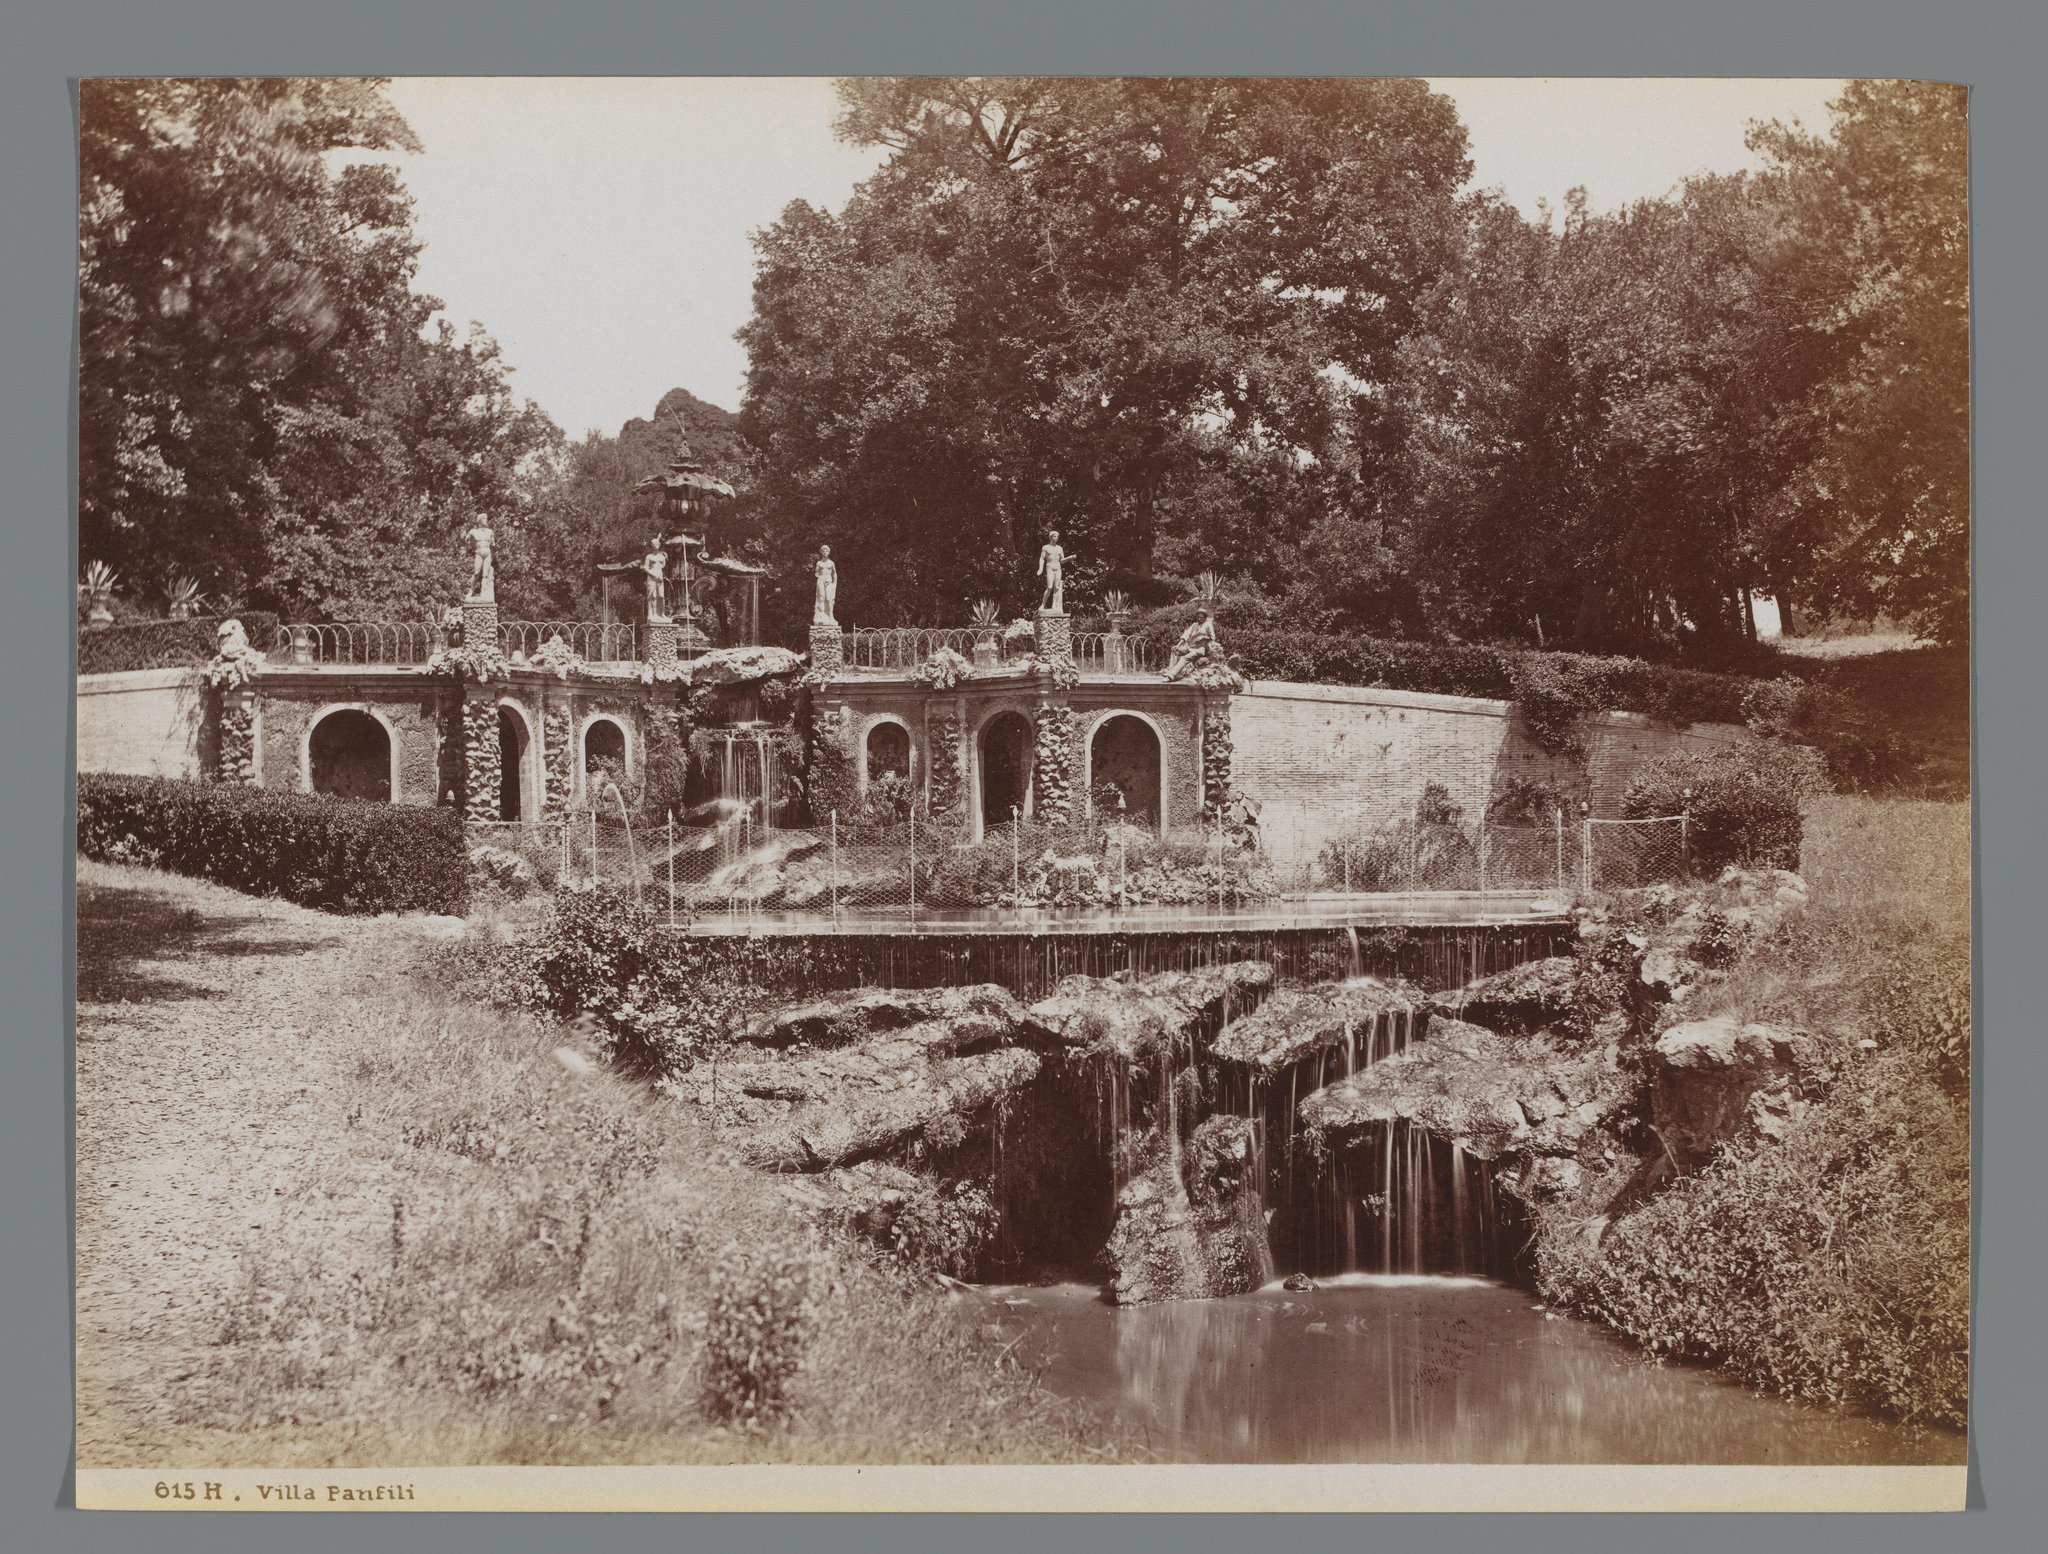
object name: photograph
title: Fontana del Giglio in de tuinen van de Villa Panfili in Rome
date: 1851-1900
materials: paper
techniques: albumen print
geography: rome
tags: french or architectonic garden; formal garden, ornamental fountain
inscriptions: collector's mark: ‘VOSMAER’, number: ‘615H.’